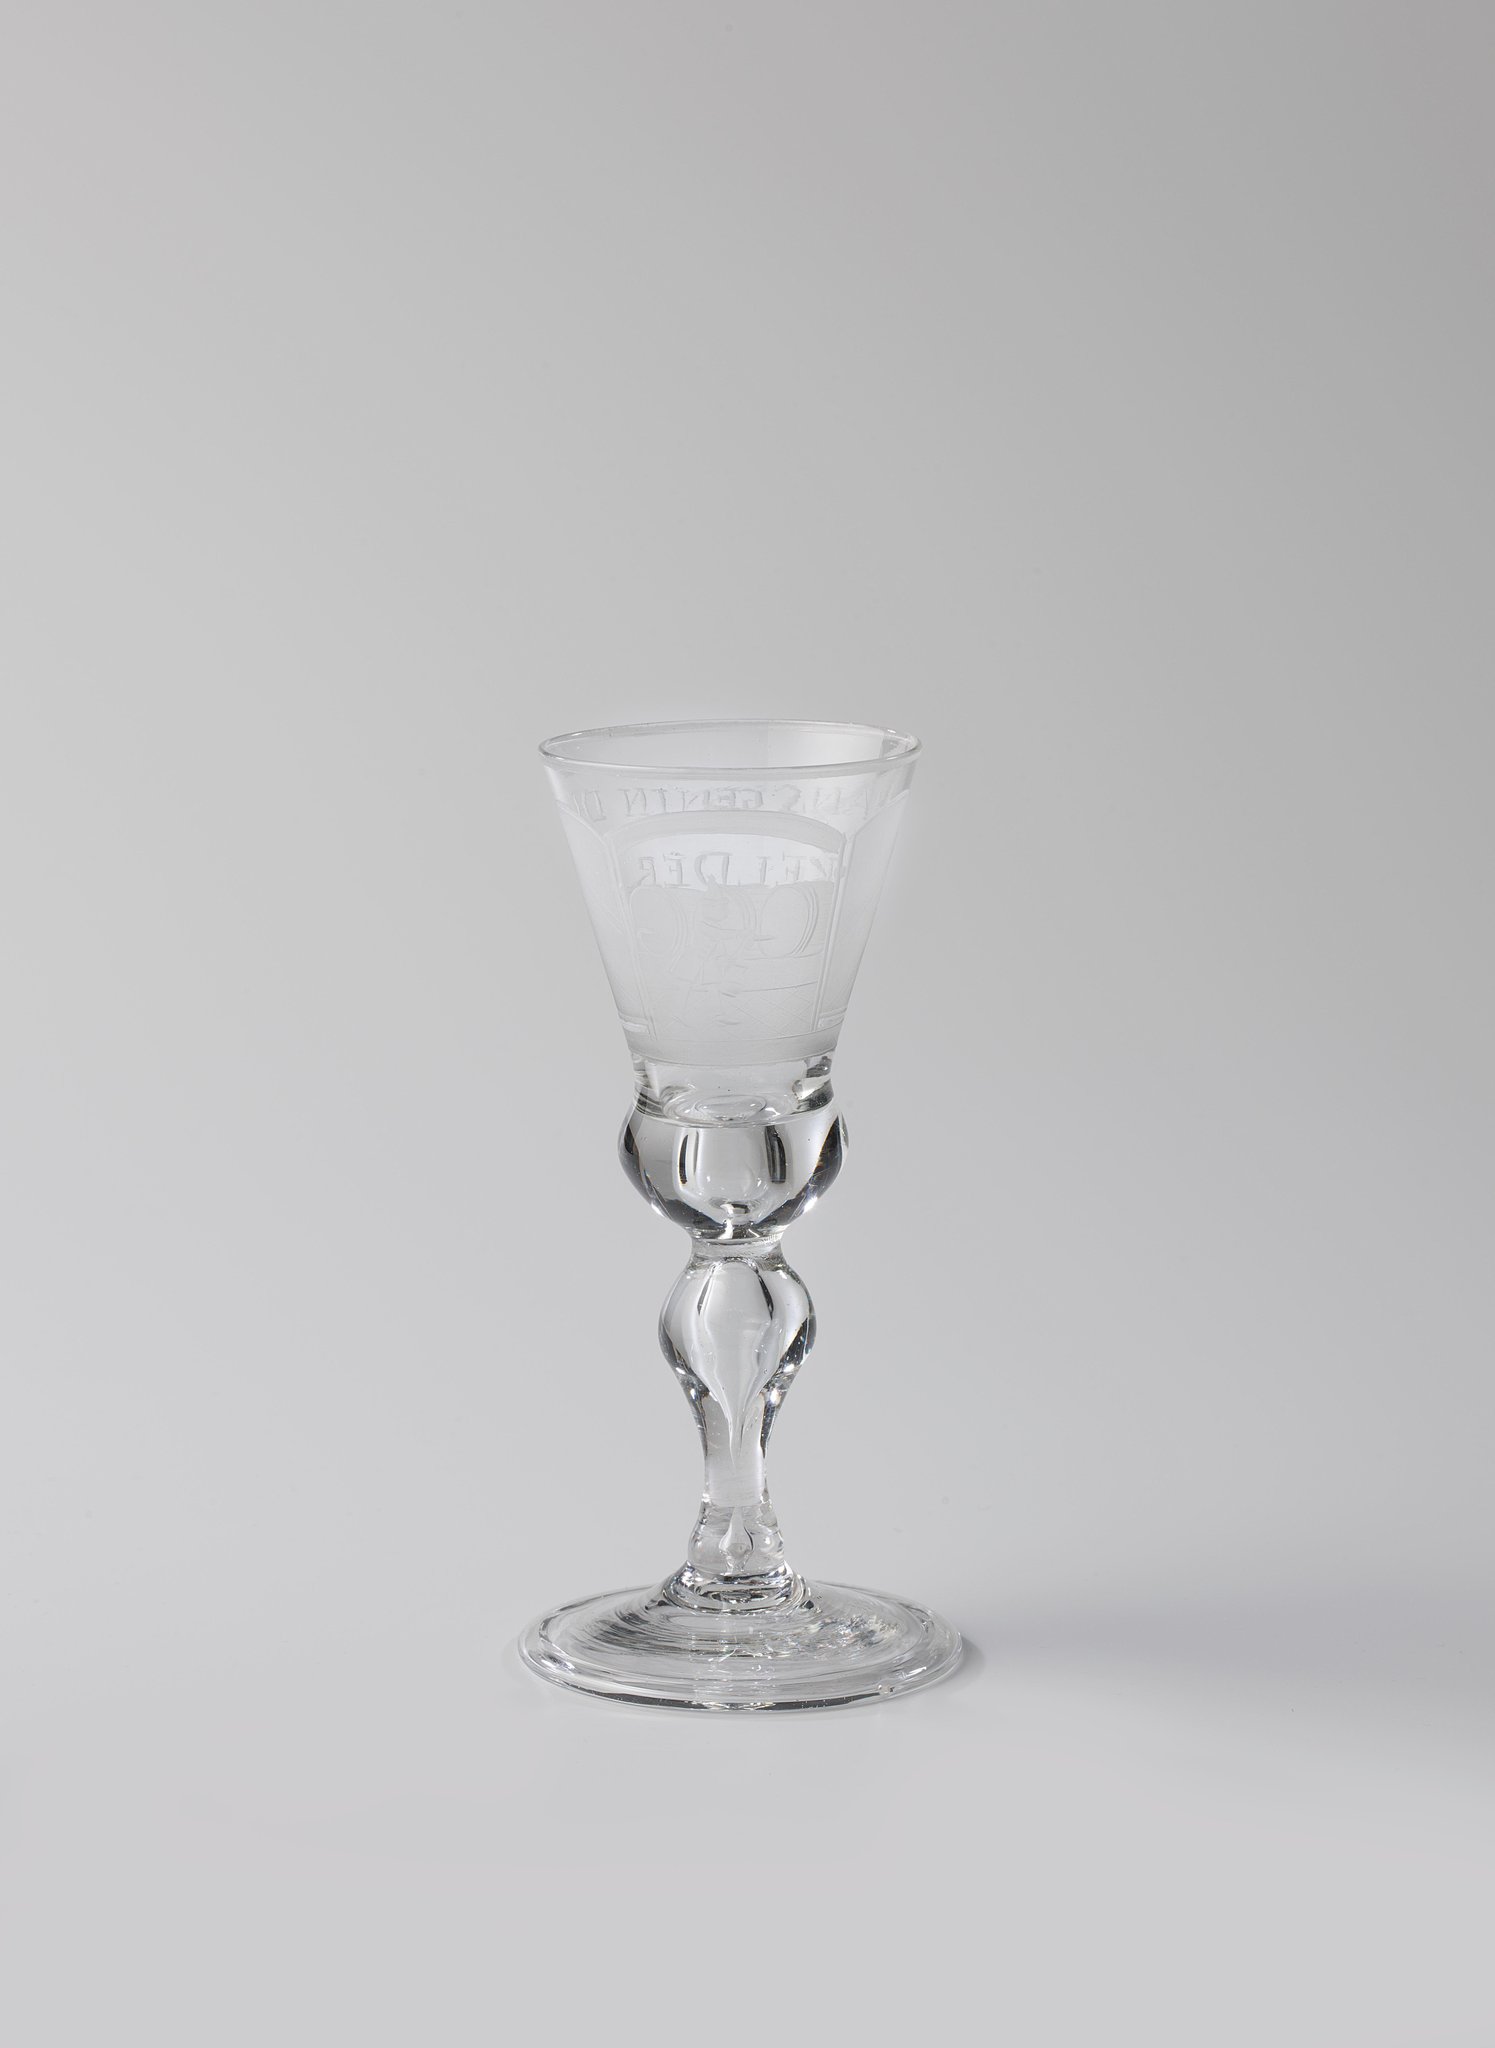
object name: goblet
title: Bokaal met een man in een kelder met vaten en het opschrift: HANSGENIN DE/ KELDER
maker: Anonymous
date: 1725-1750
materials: glass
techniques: glassblowing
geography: glücksburg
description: Bokaal met balusterstam en verdikt kelk ondereinde. Op de kelk het inwendige van een kelder en een man uit een vat tappende waaronder: HANSGENIN DE/ KELDER.